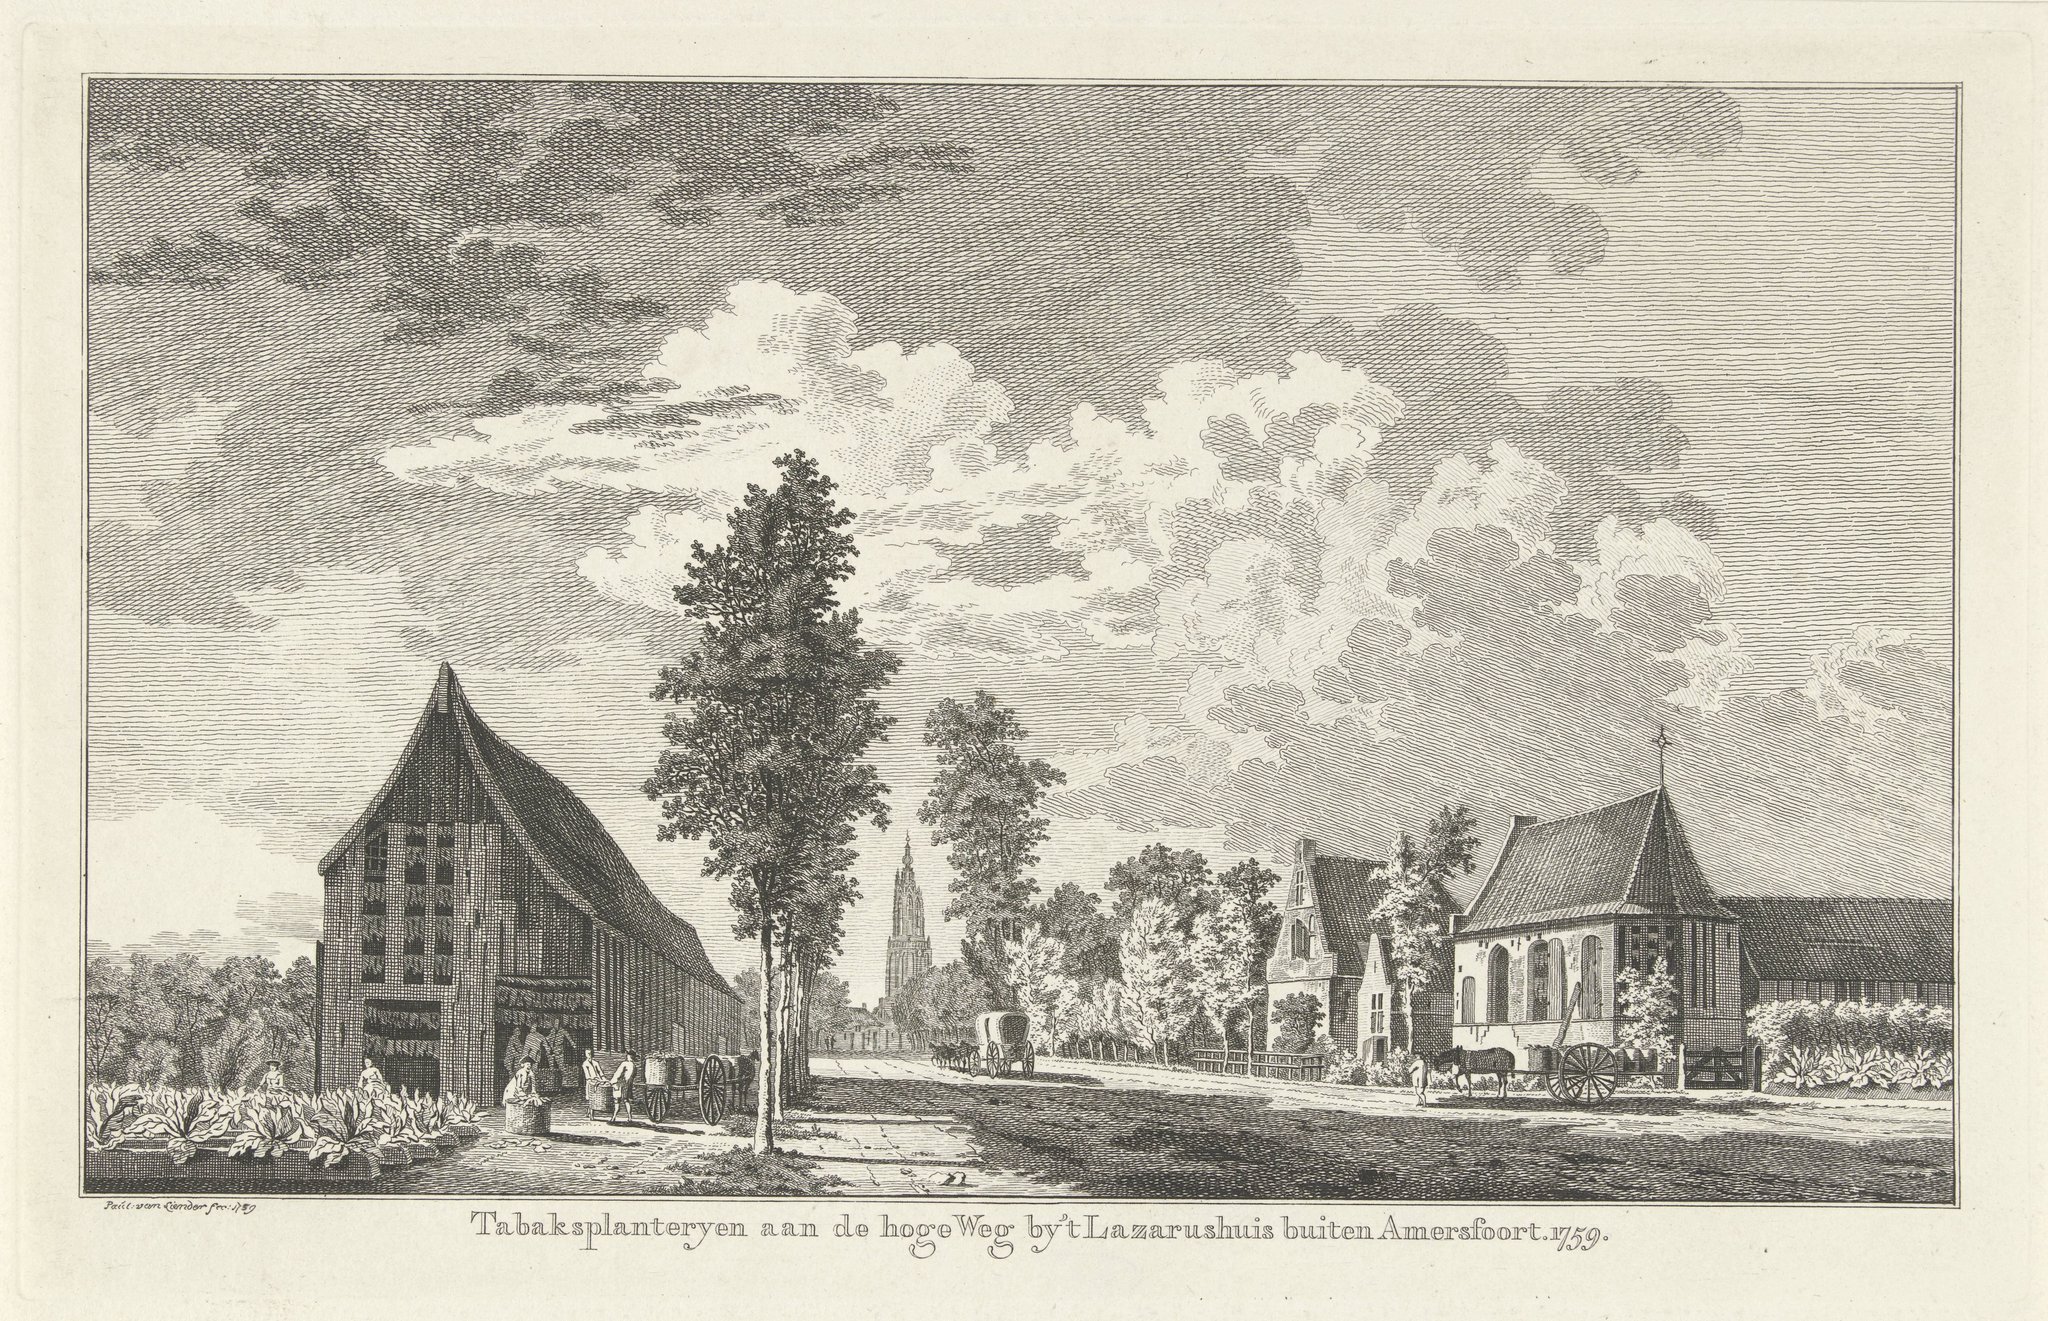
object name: print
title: Tabaksplanteryen aan de hoge weg by't Lazarushuis buiten Amersfoort. 1759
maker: paulus van liender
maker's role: draughtsman, print maker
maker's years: 1731-1797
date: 1759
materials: paper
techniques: etching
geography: utrecht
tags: plantation (+ variant), tobacco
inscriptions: collector's mark: Lugt 2228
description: Prent ook gebruikt in: Bemmel, Abraham van. Beschryving der stad Amersfoort […]. 2 delen. Utrecht: Henrikus Spruit, 1760.